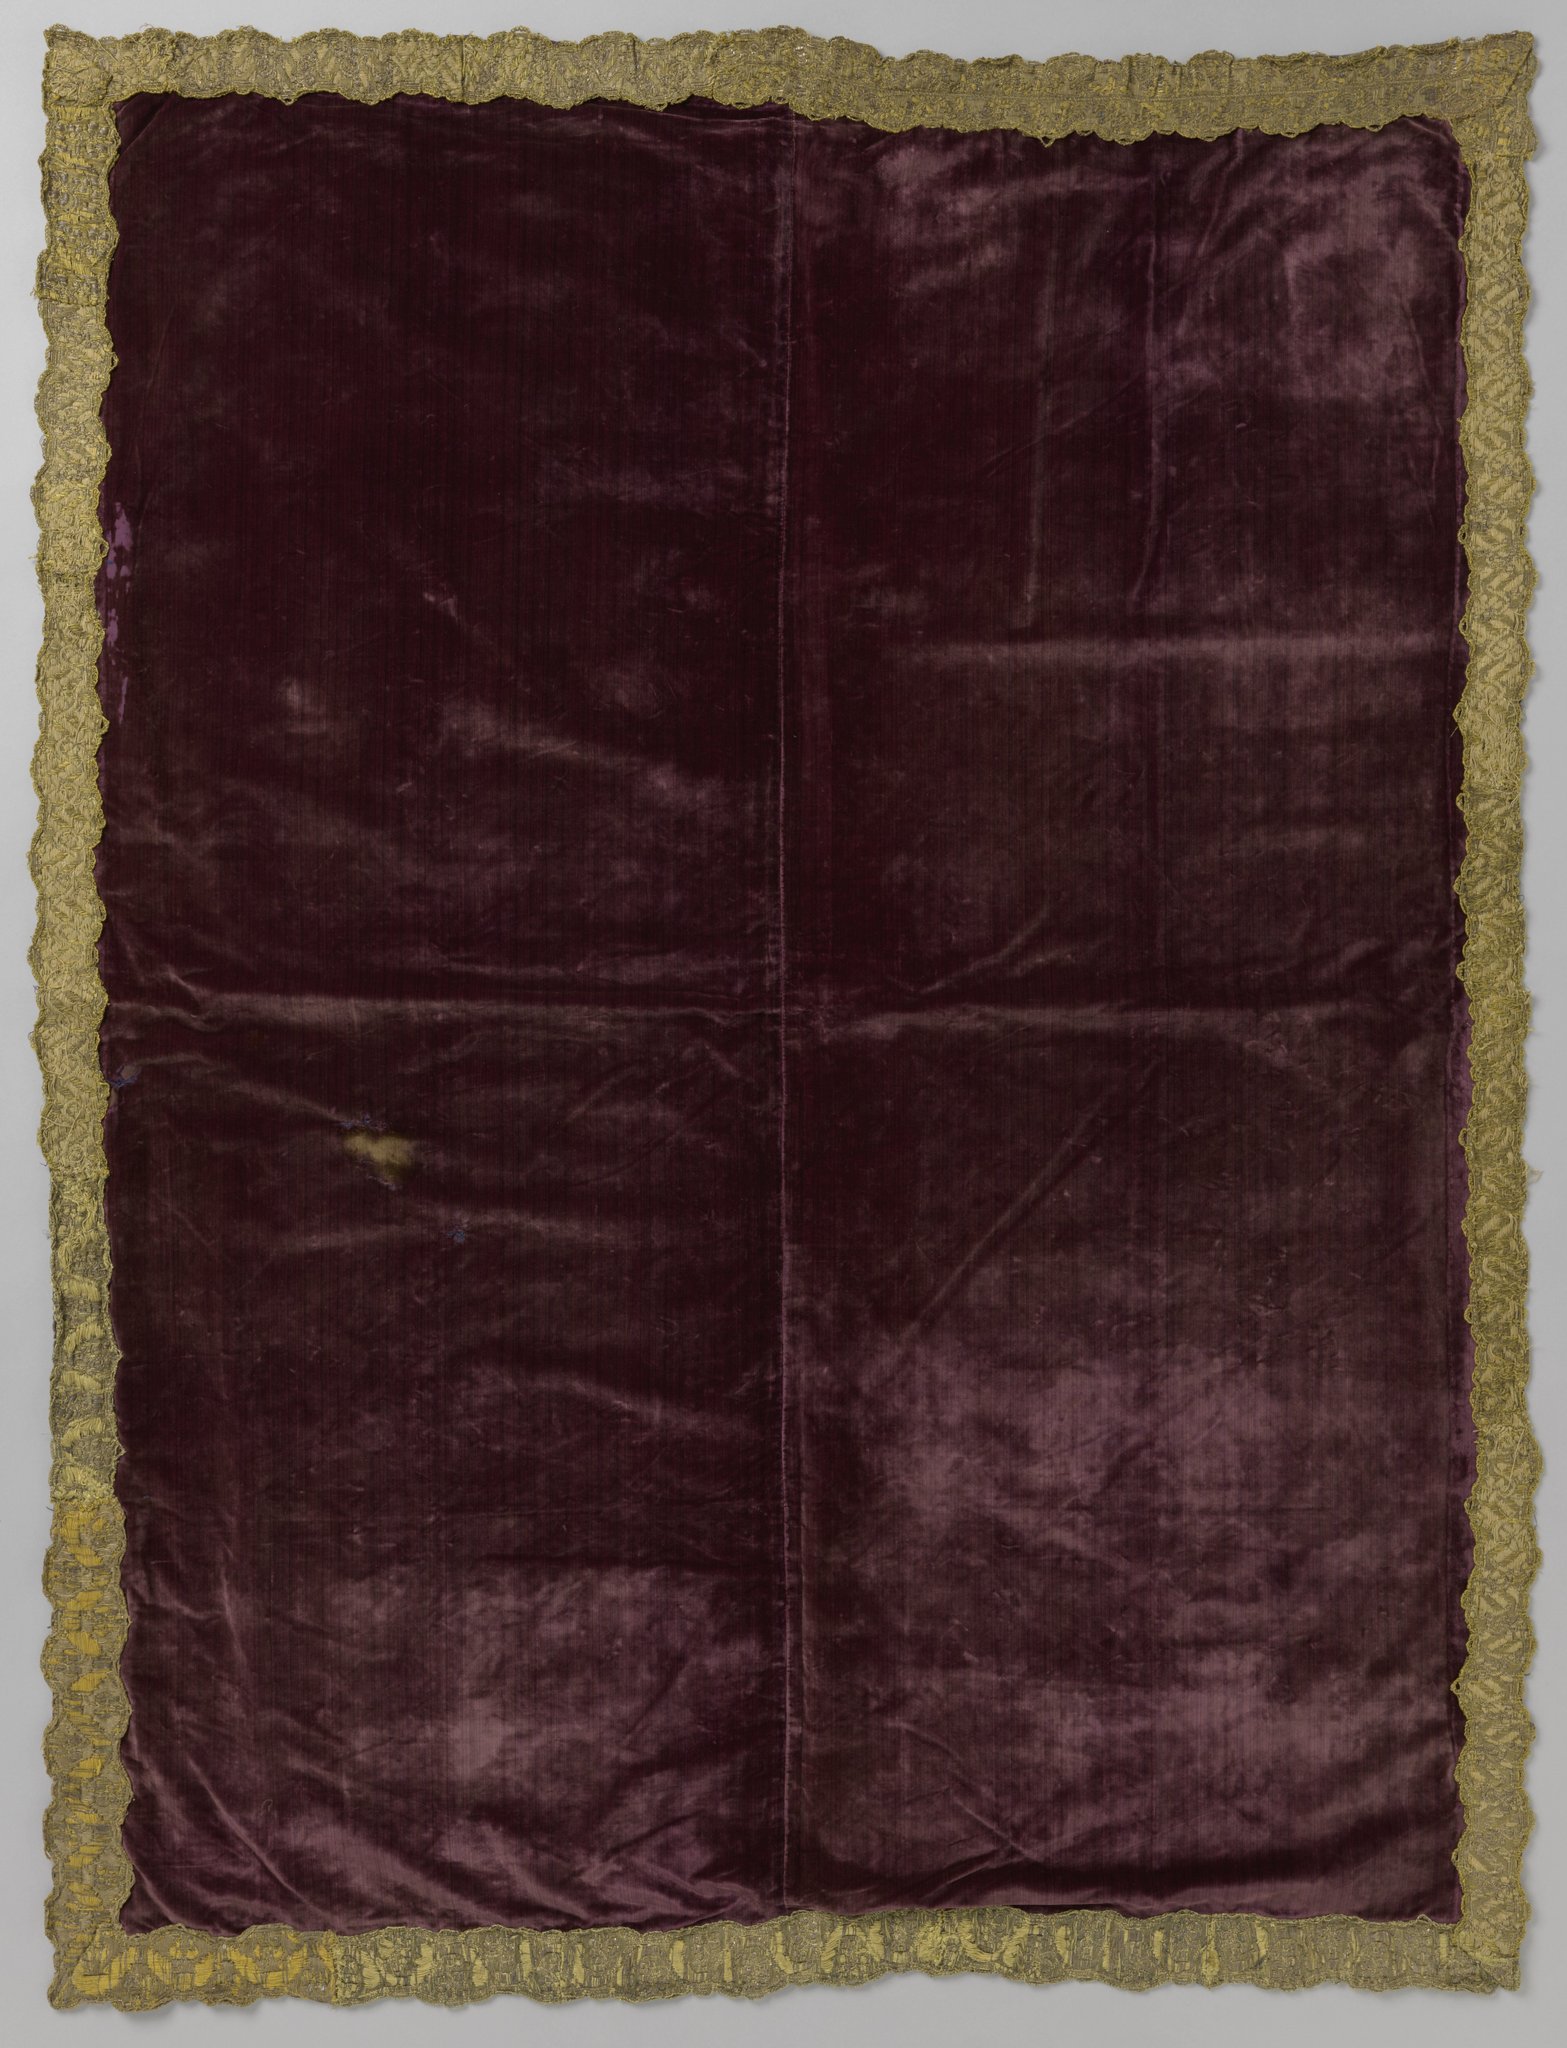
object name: tafelkleed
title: Tafelkleed van zijden fluweel, afgewerkt met goudgalon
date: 1600-1699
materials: cotton, linen, silk, velvet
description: Tafelkleed van zijden fluweel, effen purper-paars, afgewerkt met goudgalon, waarvan de contouren gegolfd zijn.